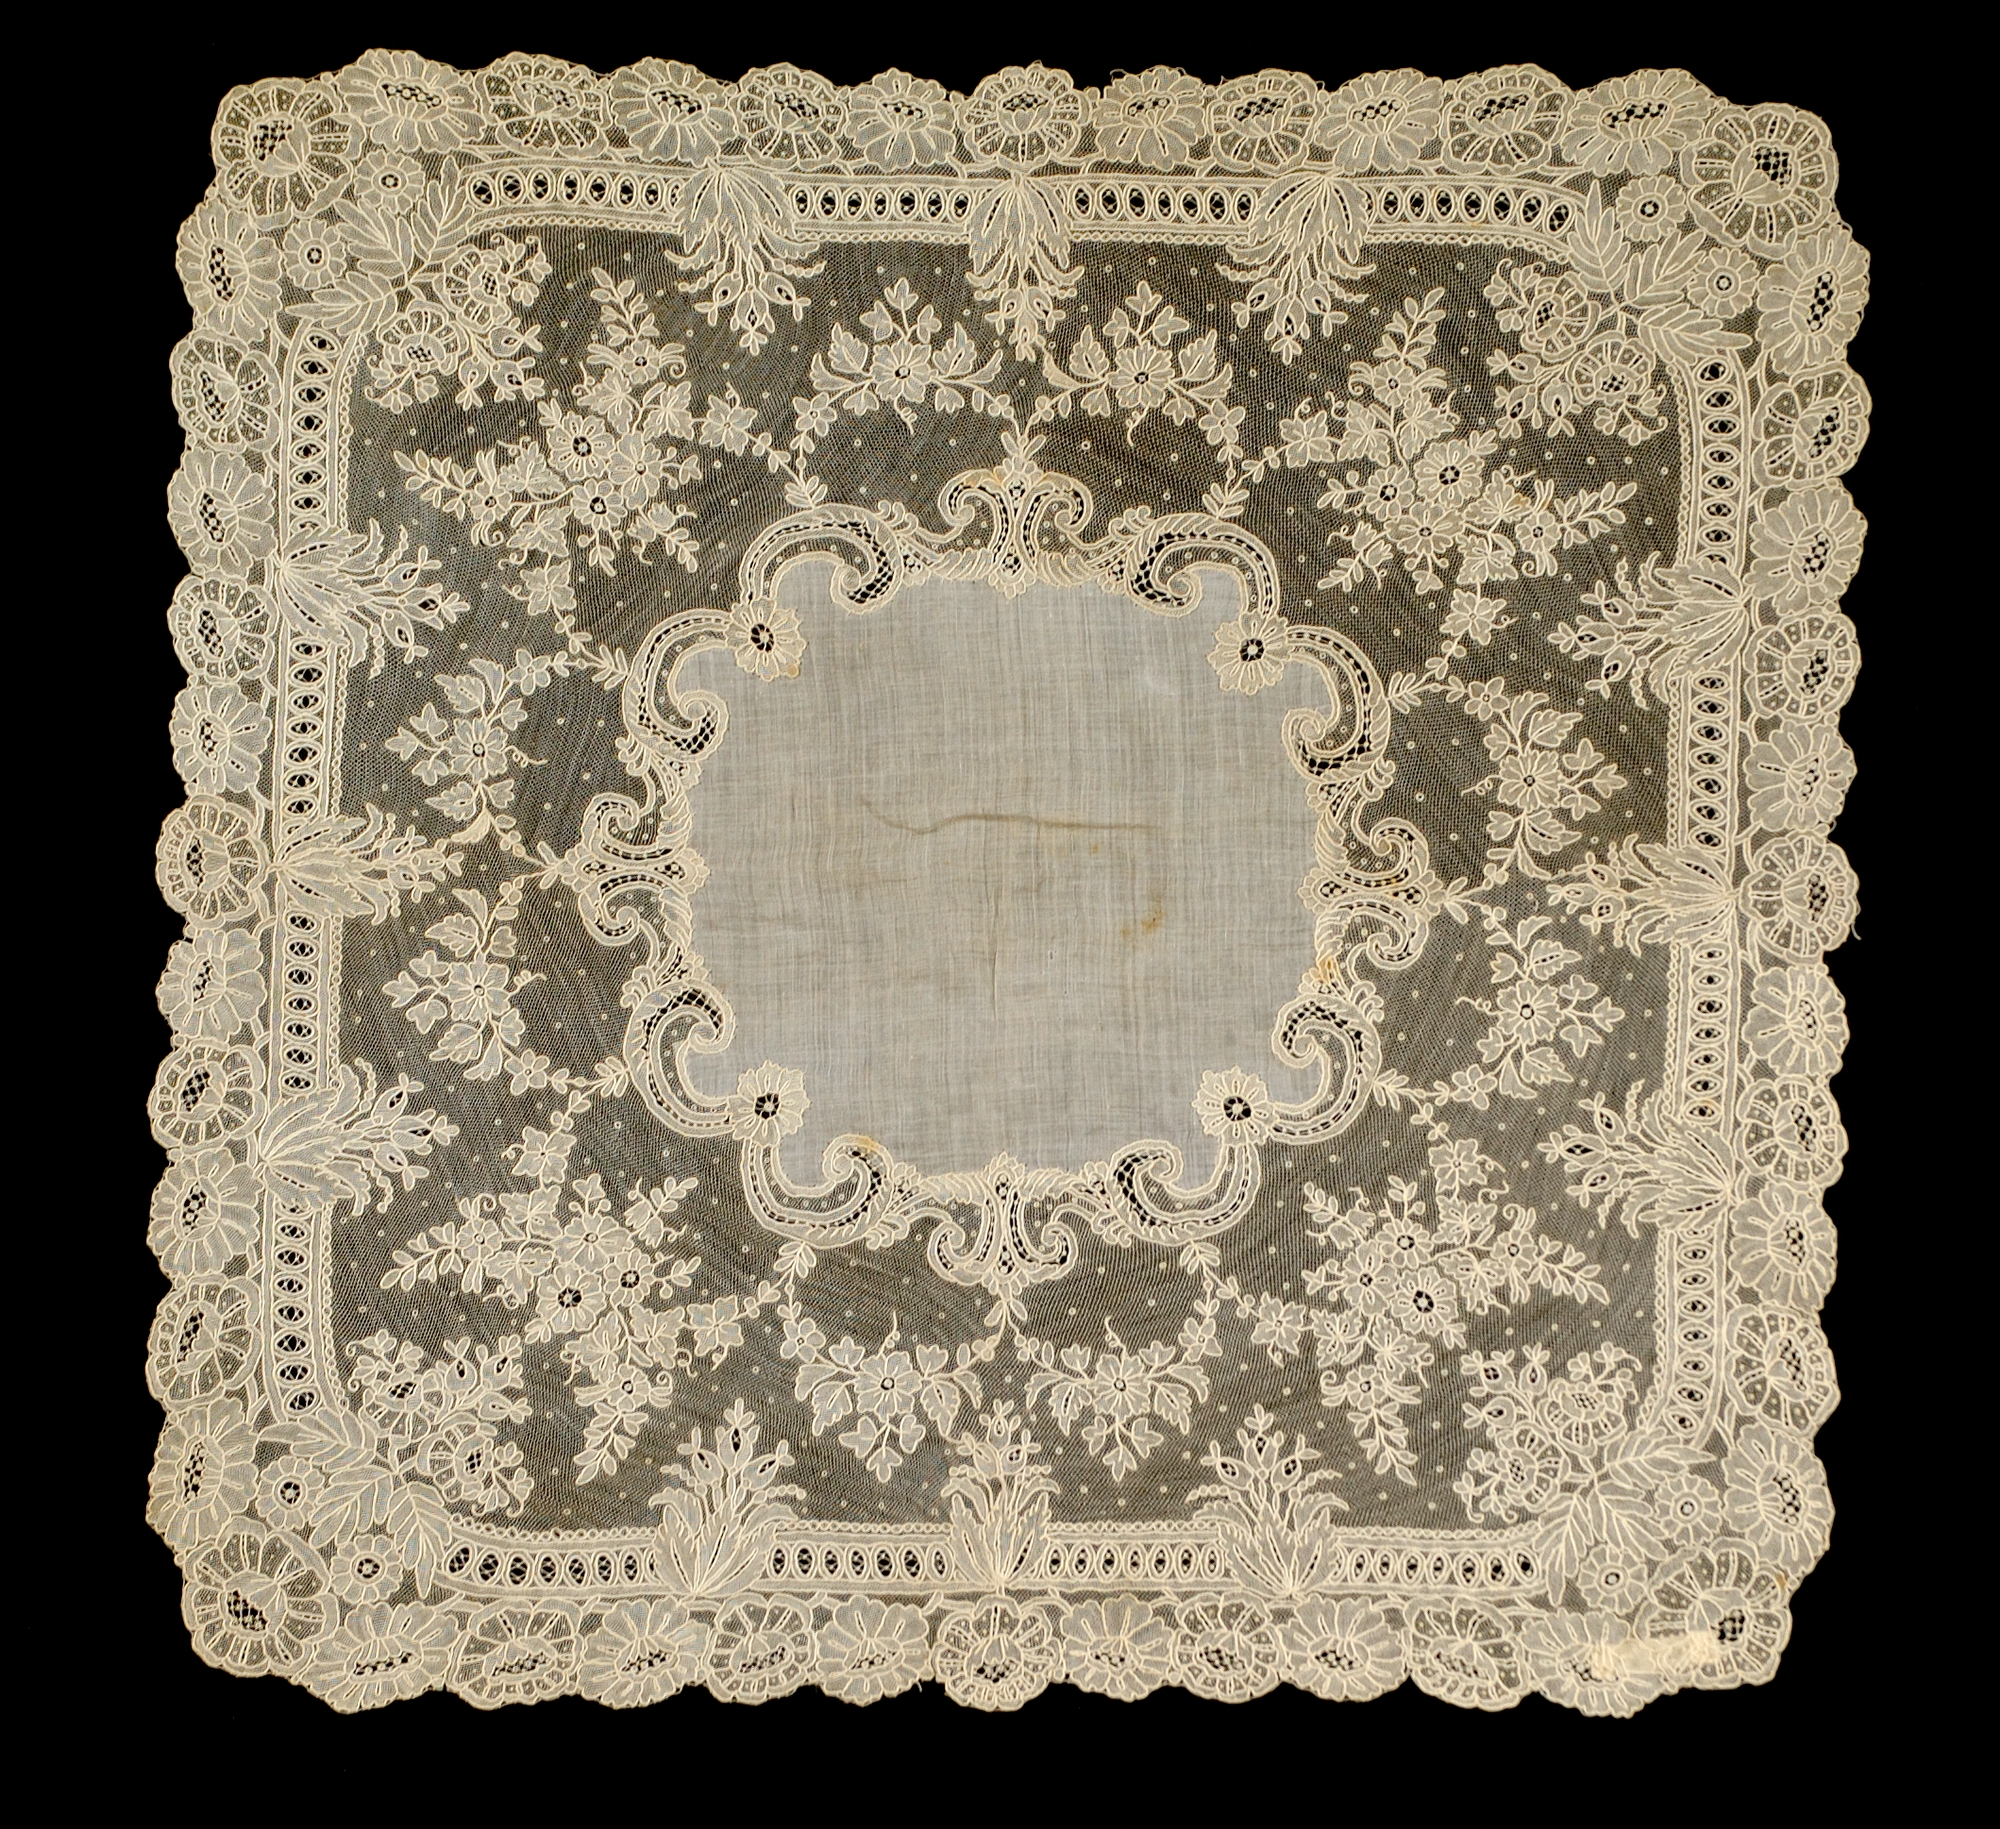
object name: handkerchief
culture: belgian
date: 1851-1875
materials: linen